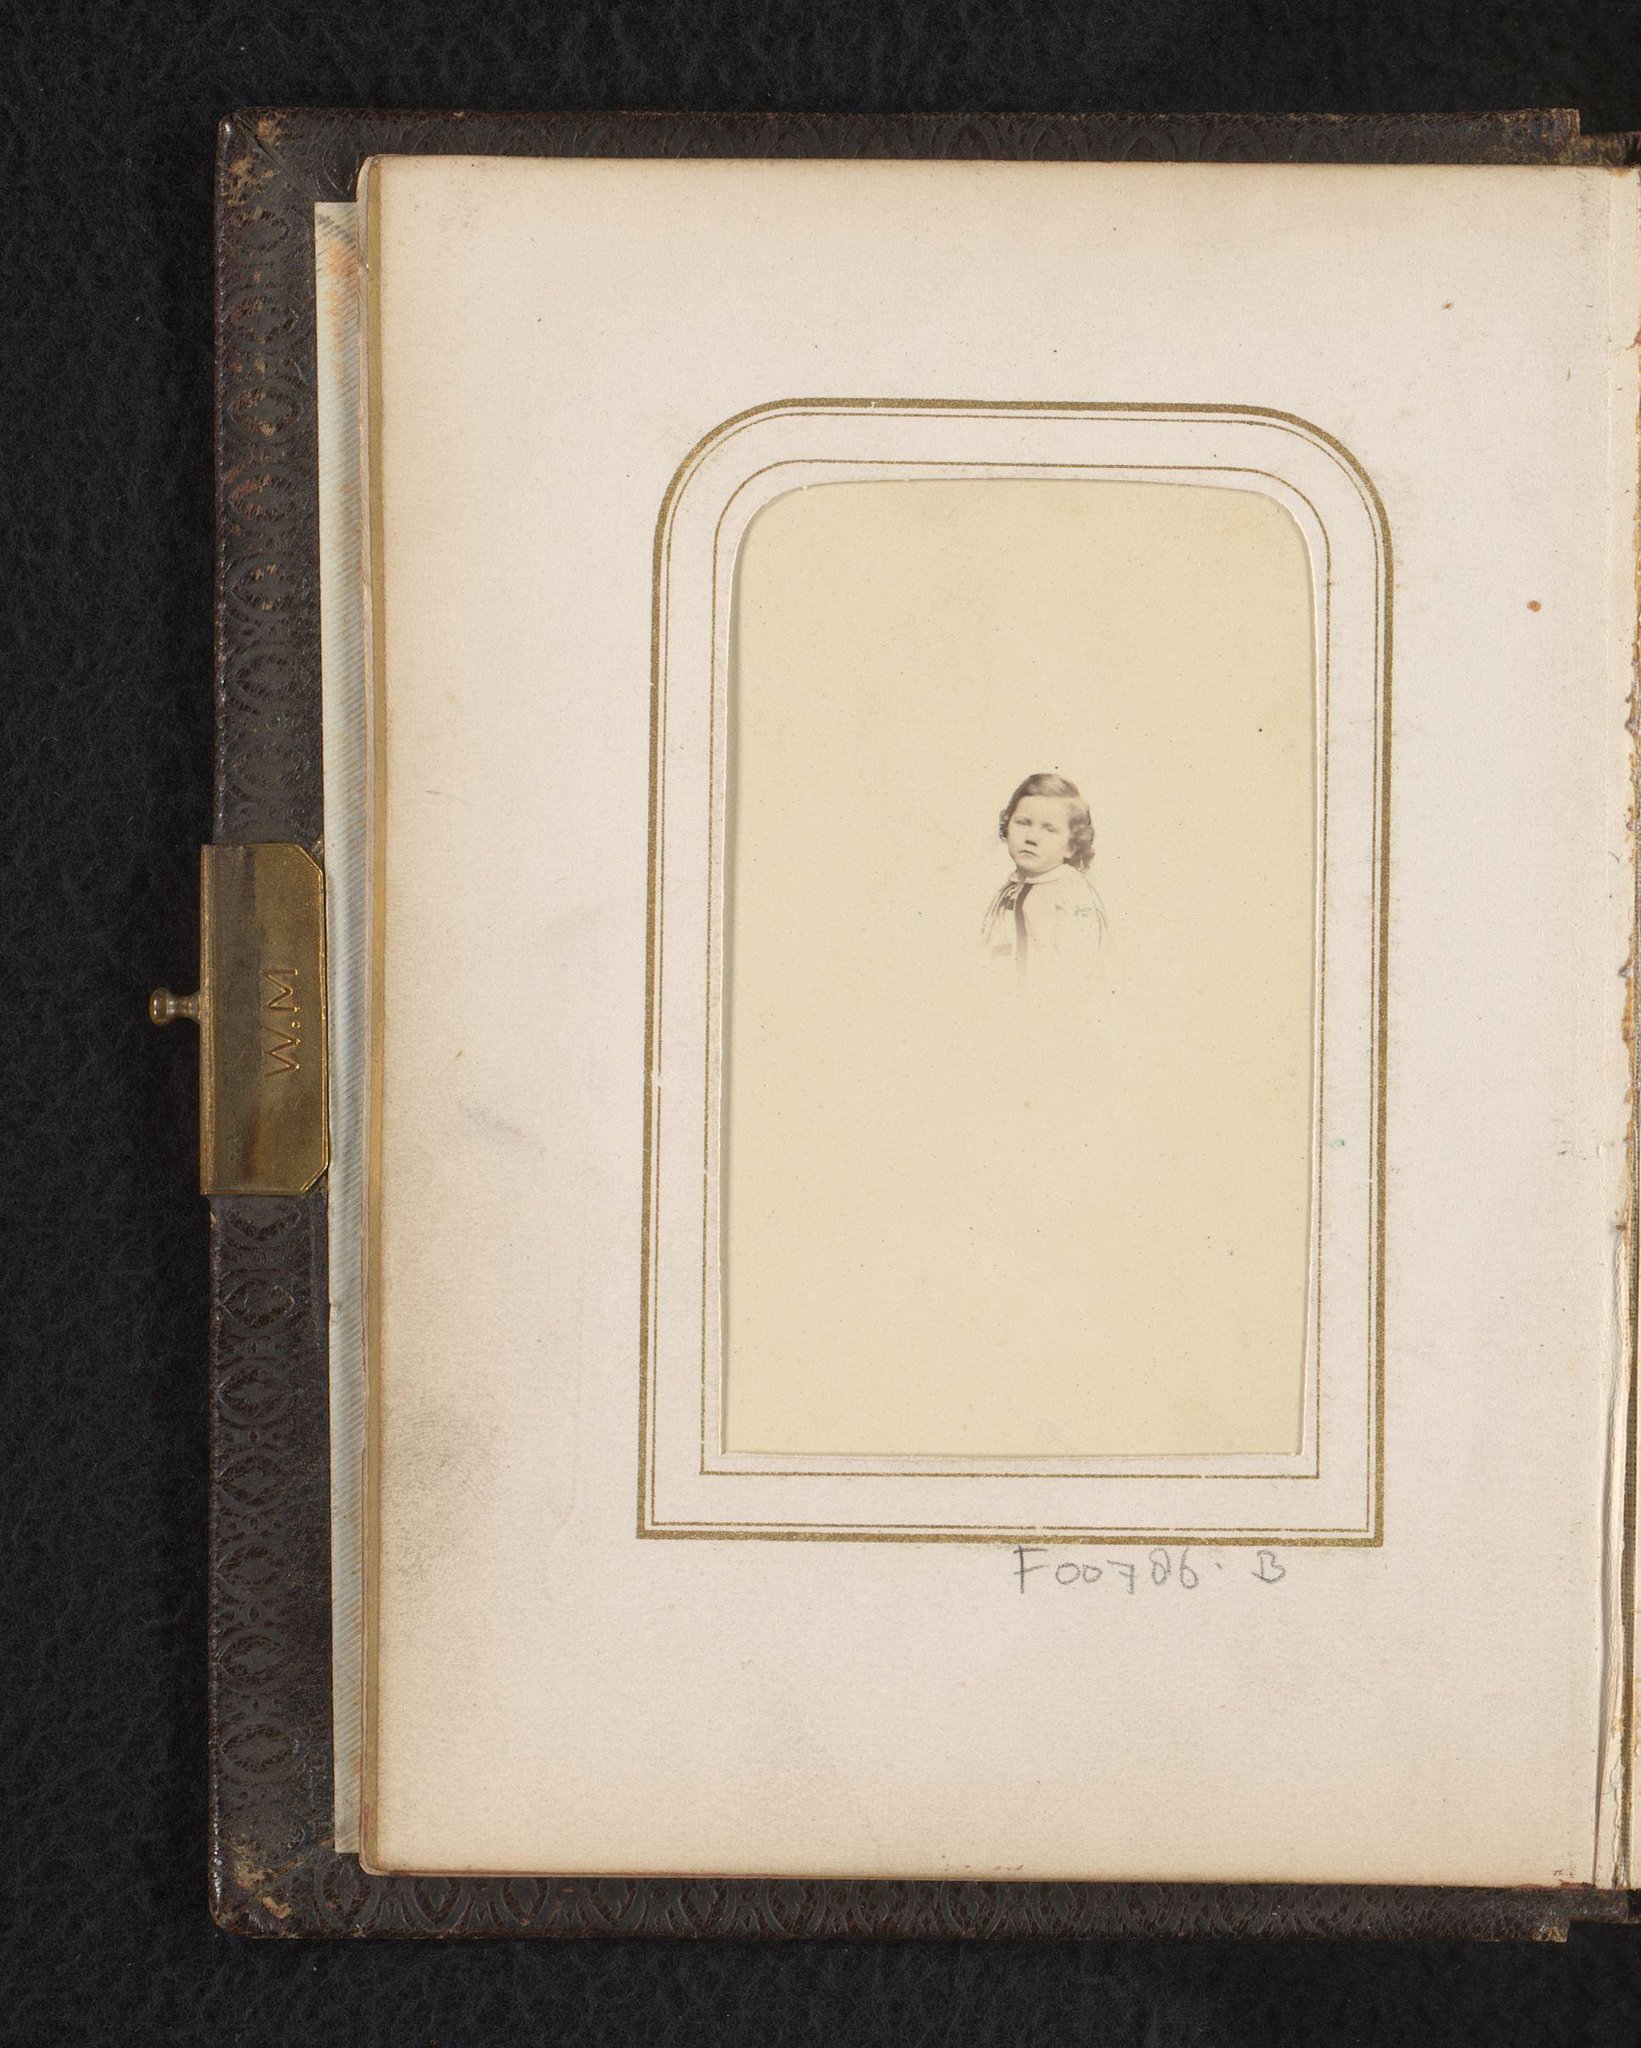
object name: photograph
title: Portret van een kind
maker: o.c. smith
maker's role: fotograaf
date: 1860-1890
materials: cardboard, photographic support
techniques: albumen print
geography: stroud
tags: child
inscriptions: inscription: ‘O.C. Smith/ George Street/ Stroud’